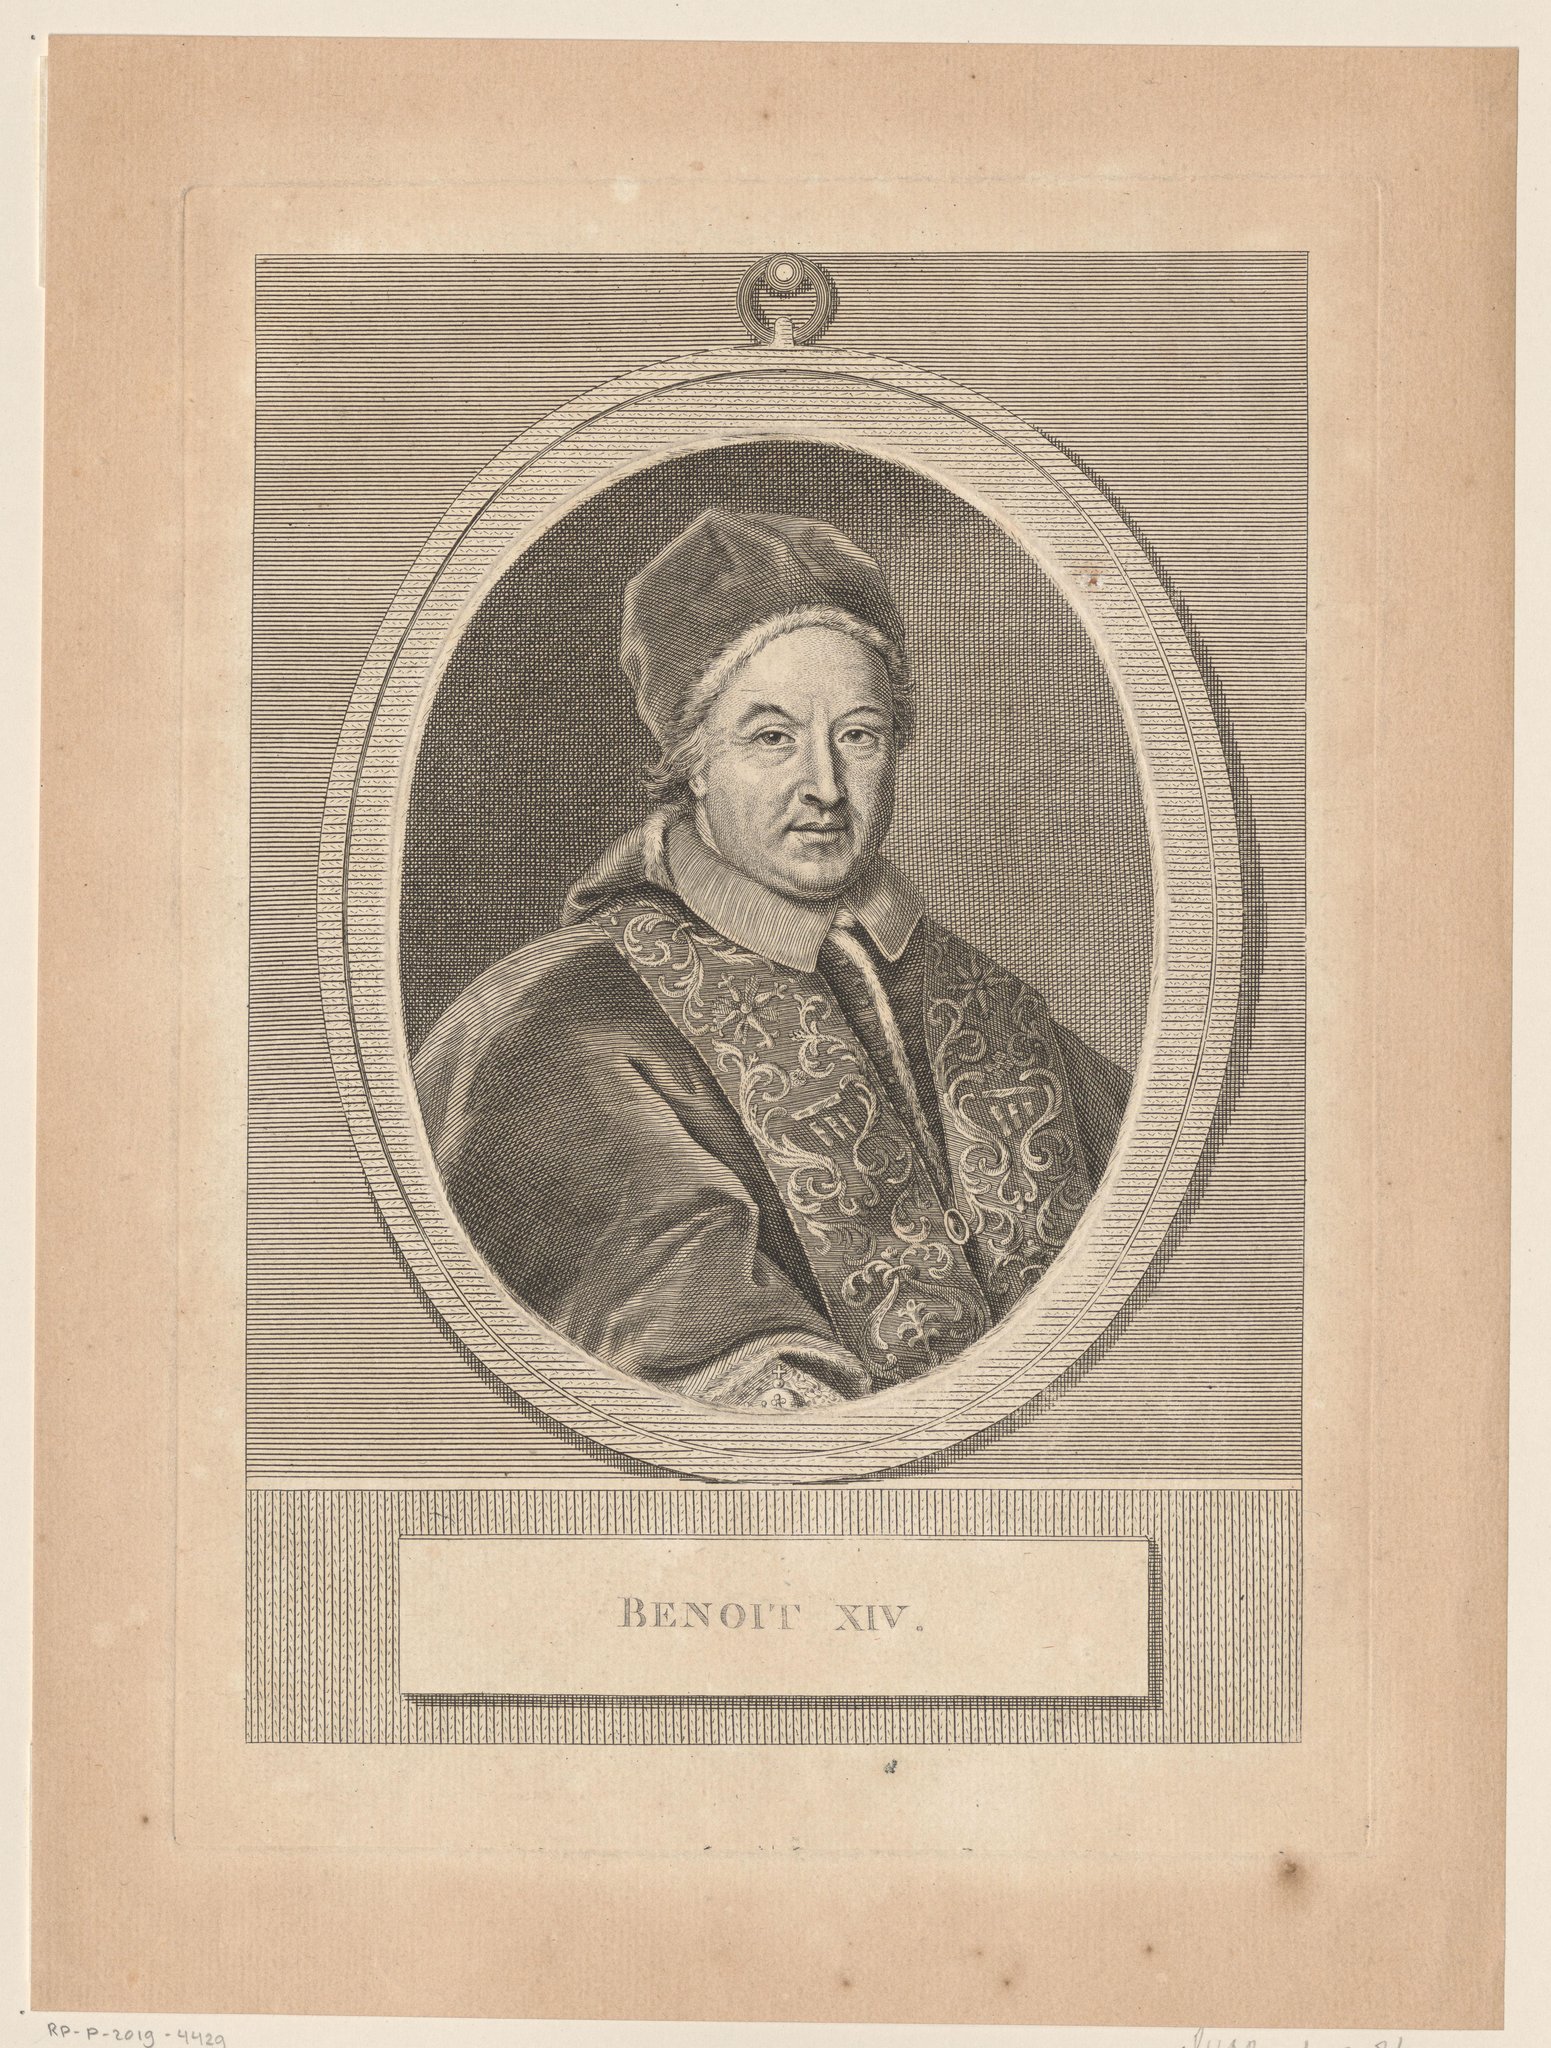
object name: print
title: Portret van paus Benedictus XIV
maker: Anonymous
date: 1740-1799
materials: paper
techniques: engraving, etching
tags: rome, clergyman, benedictus xiv, historical persons, pope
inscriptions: collector's mark: Lugt 2228